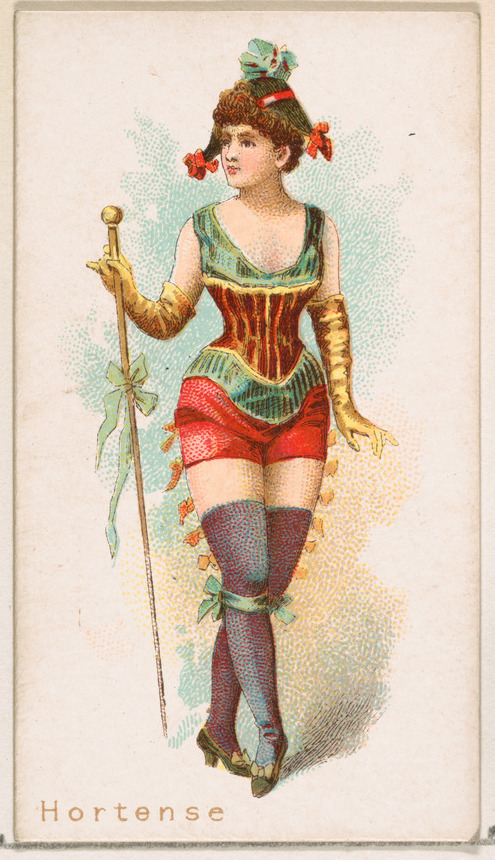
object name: print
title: Hortense, from the Ballet Queens series (N182) issued by Wm. S. Kimball & Co.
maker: william s. kimball & company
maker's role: publisher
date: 1889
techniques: color lithograph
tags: women,dancers